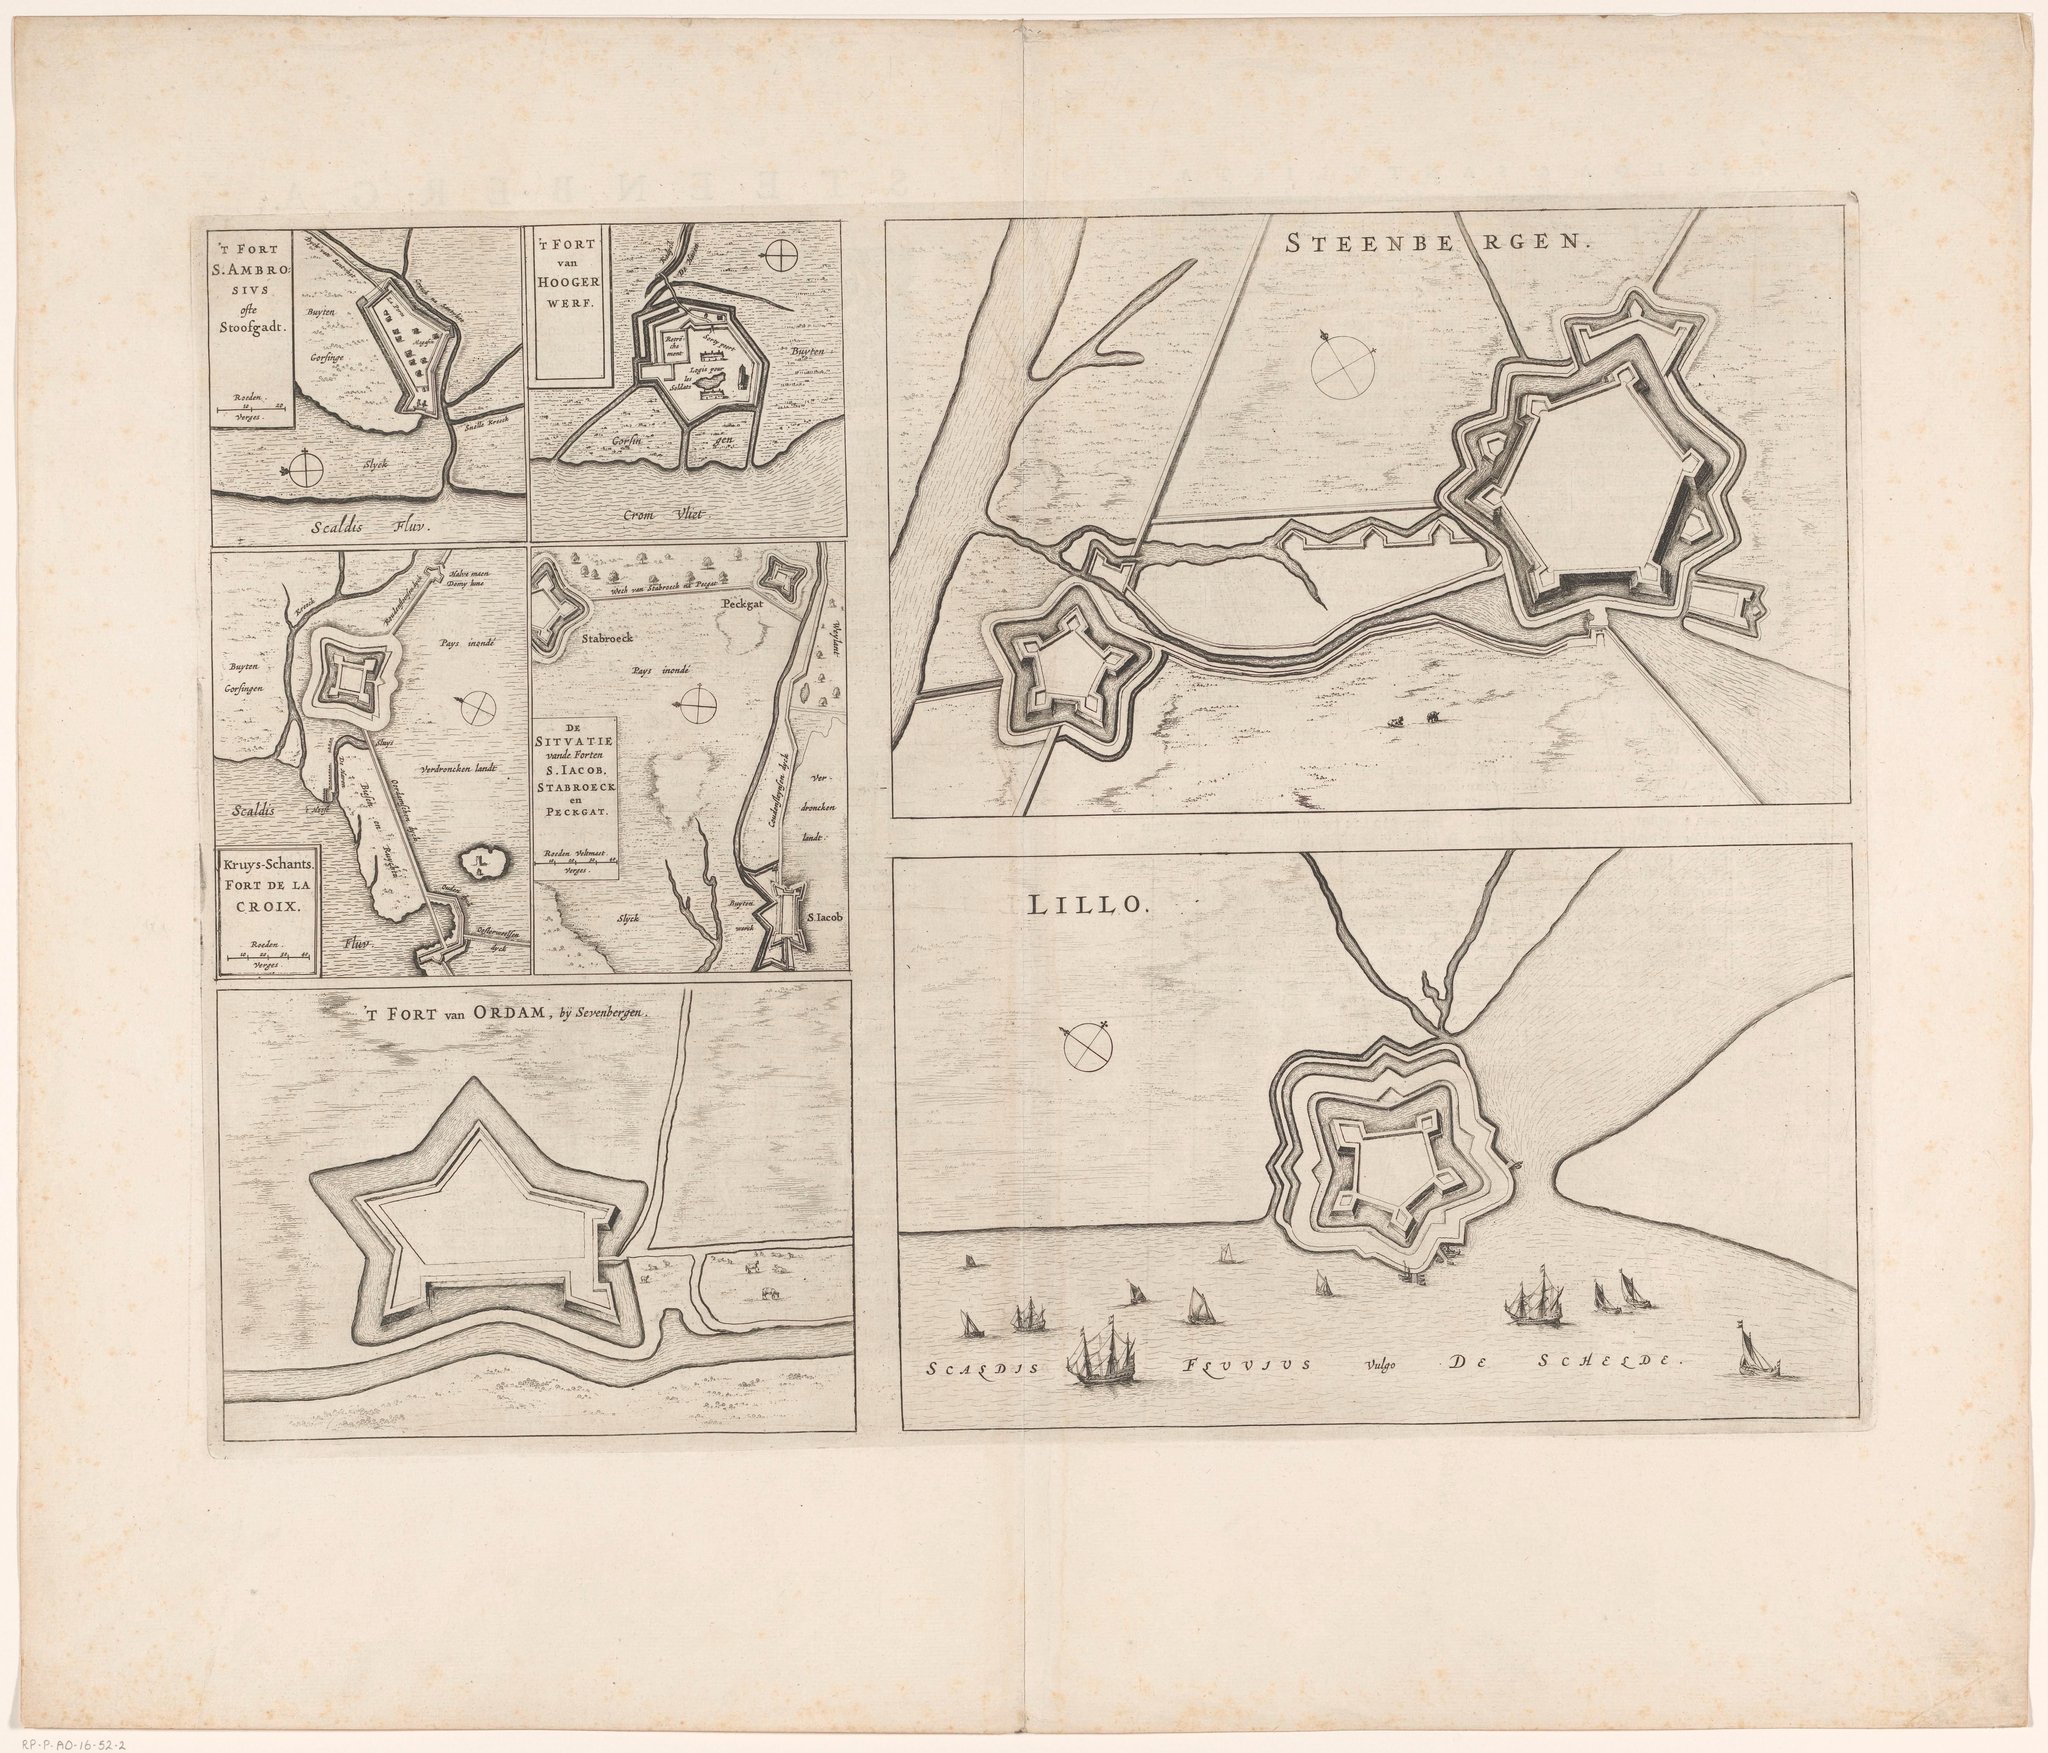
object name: area plan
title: Steenbergen / Lillo / 't Fort S. Ambrosius / 't Fort van Hoogerwerf / Kruys-Schants. Fort de la Croix / De situatie vande Forten S. Jacob, Stabroeck en Peckgat / 't Fort van Ordam by Sevenbergen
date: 1652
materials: paper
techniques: engraving, etching, letterpress printing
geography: amsterdam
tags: fortified city, maps of cities, zeeland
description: Aan de linkerkant van het blad vijf kleinere plattegronden van zeven forten in Zeeuws-Vlaanderen, Vlaanderen en Brabant, elk met schaalstok. Te zien zijn: Fort Sint-Ambrosius, Fort Sint-Martijn, de Kruisdijkschans, Fort Sint-Jacob, Fort van Stabroek, Fort Pekgat en Fort Noordam. Boven, aan de rechterkant van het blad, een vestingplattegrond van Steenbergen. Onder een schaalstok: Schale van 100 Roede. Onder, aan de rechterkant van het blad, een vestingplattegrond van Fort Lillo. Links een schaalstok: Schale van 100 Roede. Op verso Latijnse tekst.